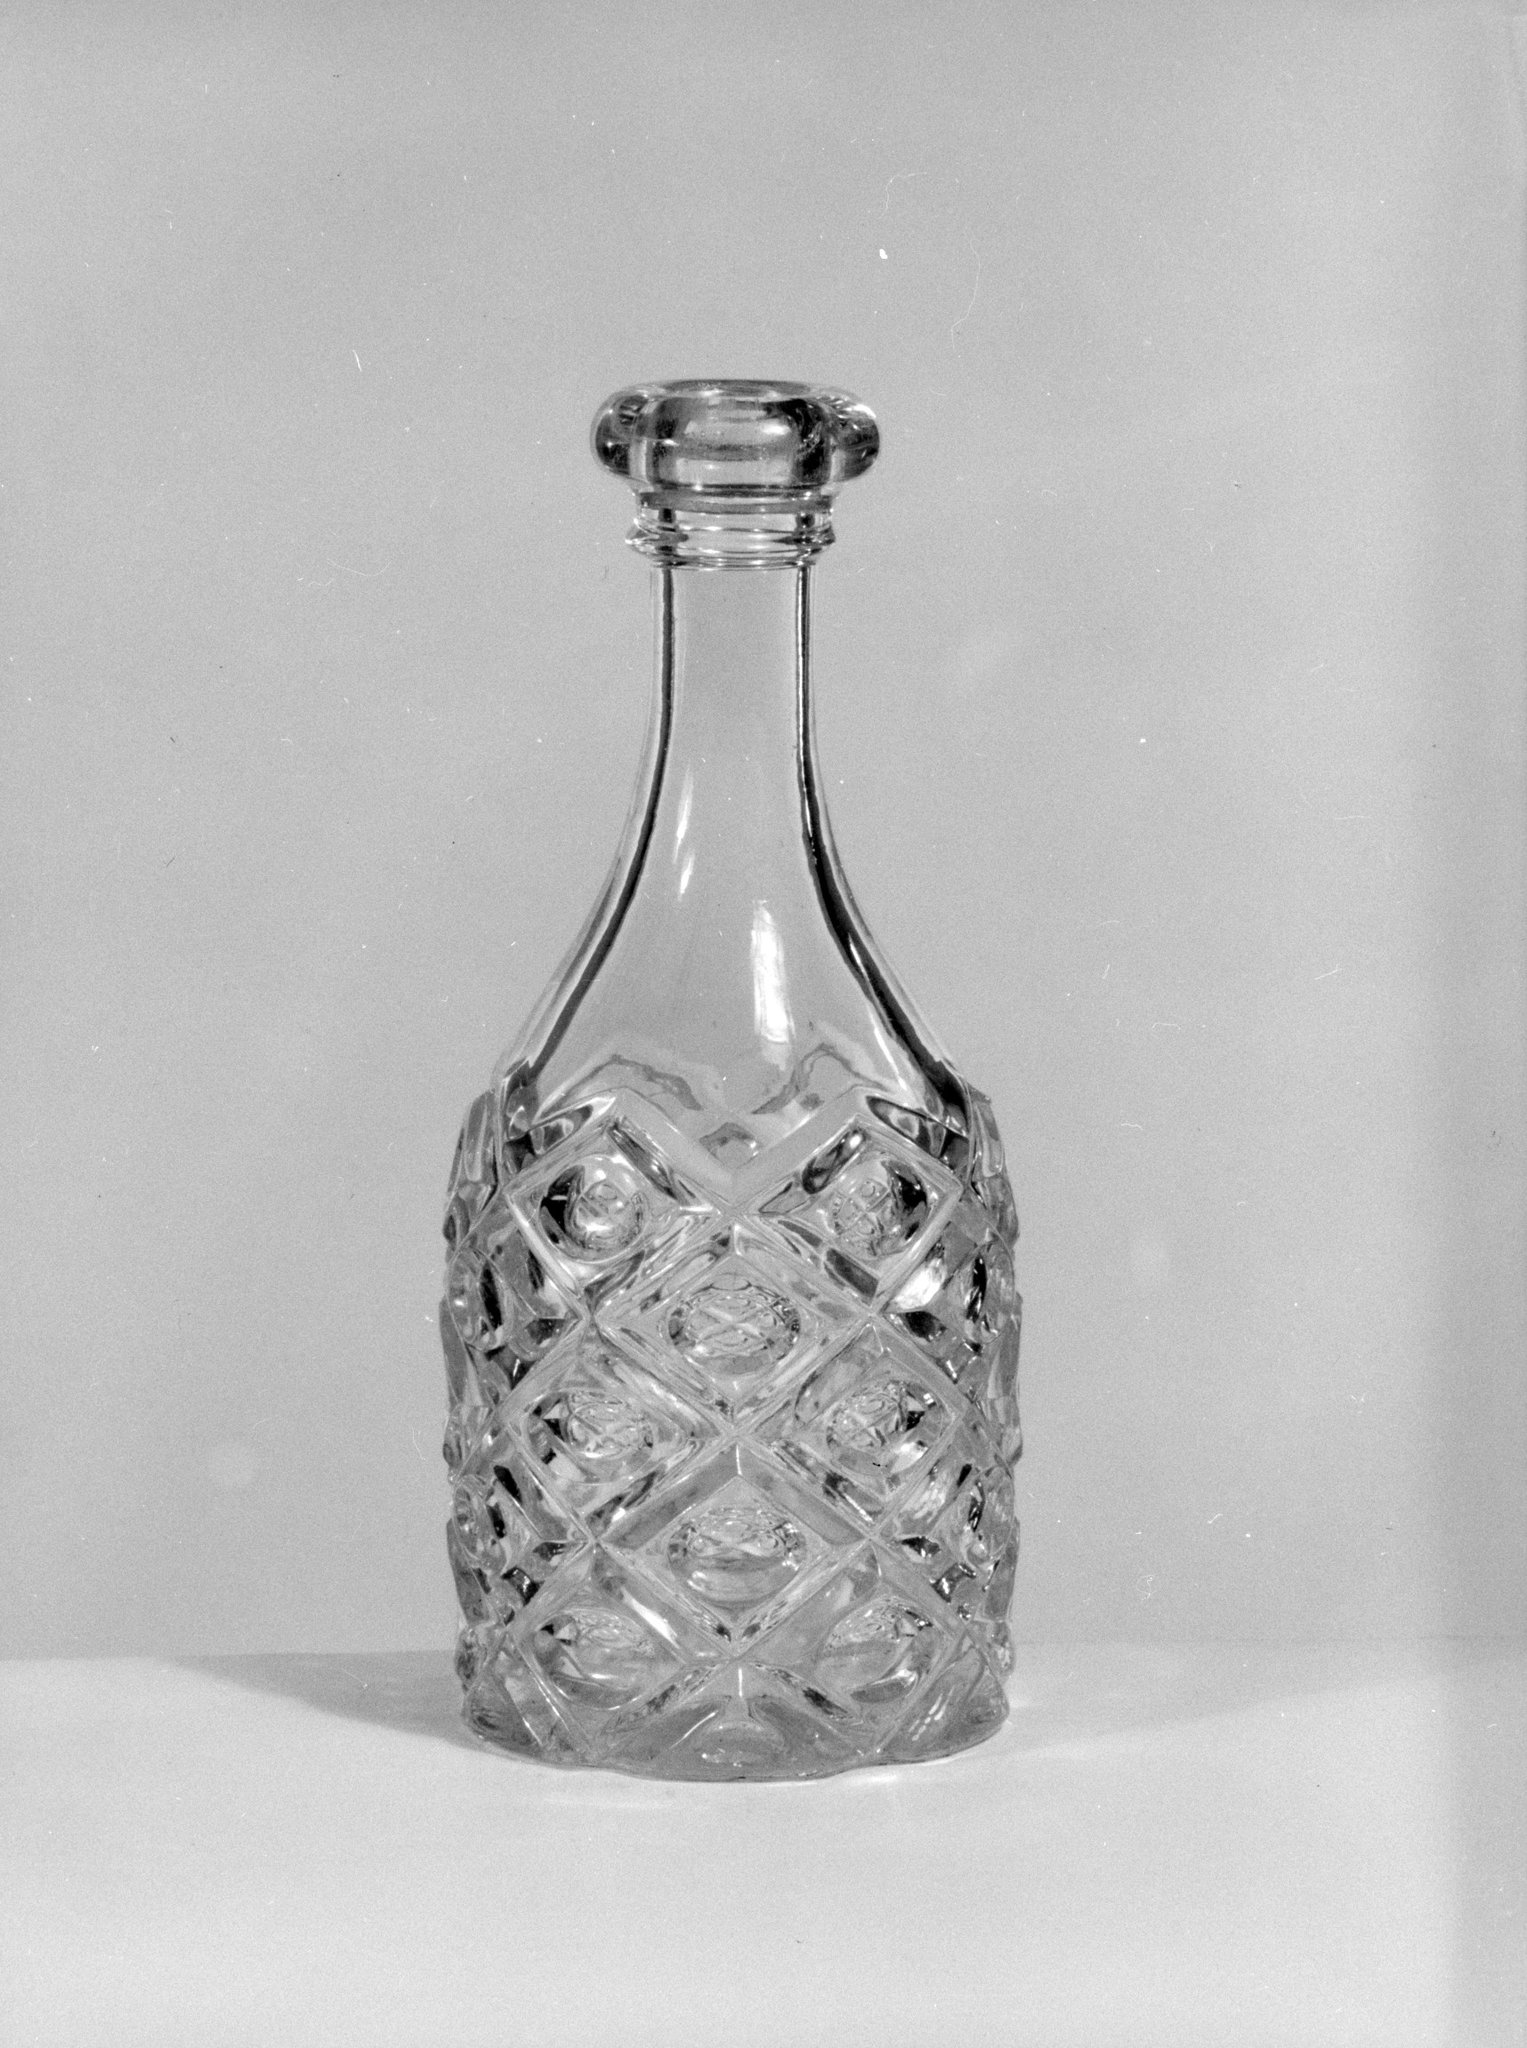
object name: pint decanter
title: Half-pint Decanter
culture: american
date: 1850-1870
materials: diamond, glass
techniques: pressed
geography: united states